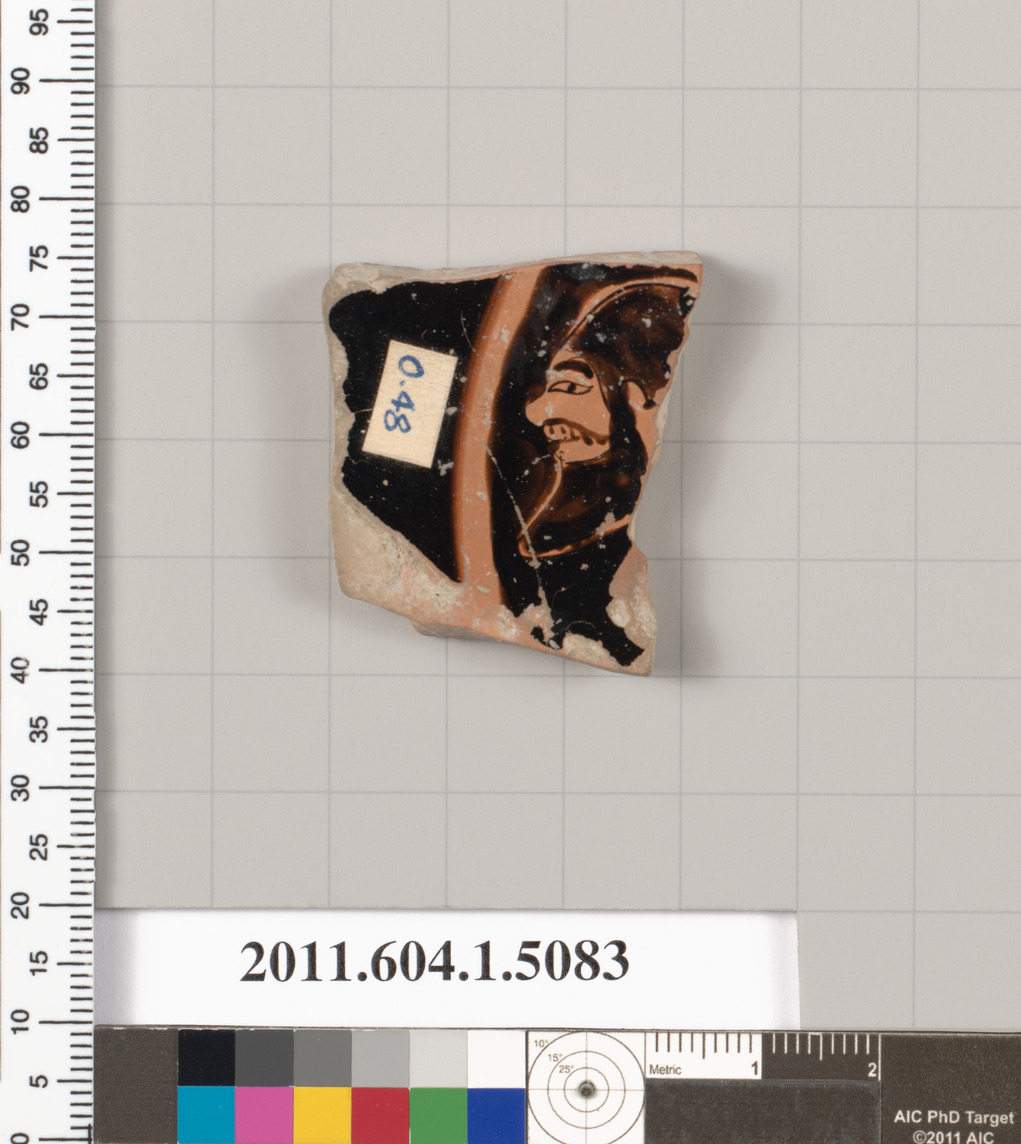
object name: kylix fragment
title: Terracotta fragment of a kylix (drinking cup)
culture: greek, attic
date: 520-500 BCE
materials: terracotta